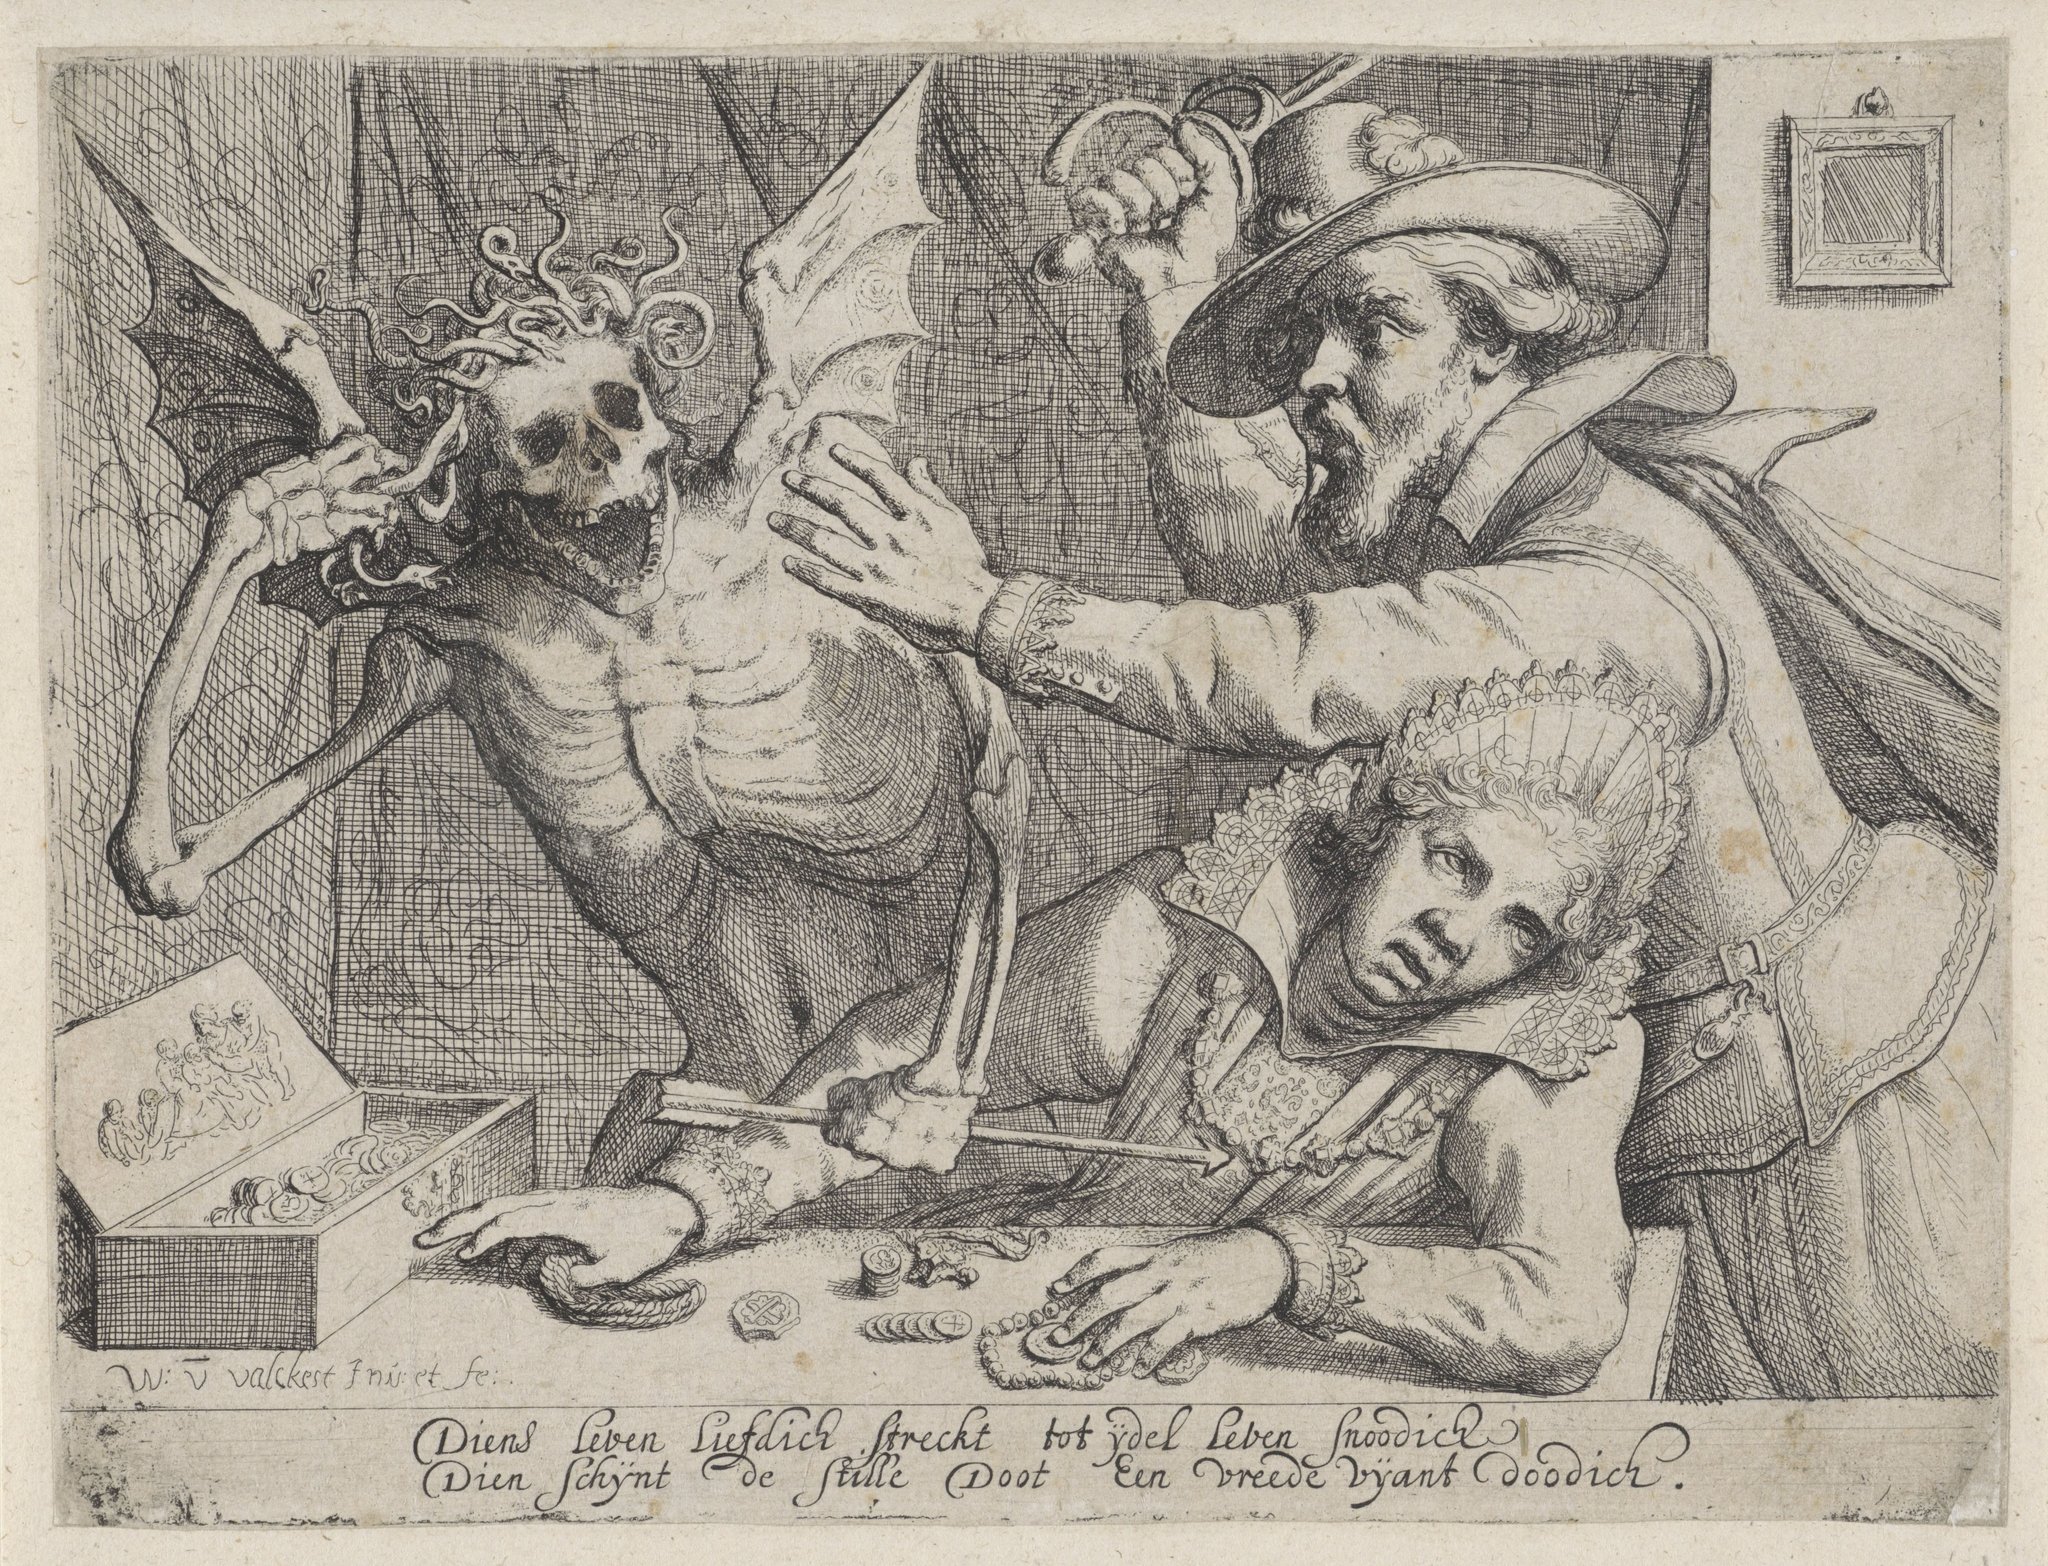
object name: print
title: Jong paar en de Dood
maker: werner van den valckert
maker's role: draughtsman, painter, print maker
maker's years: 1580-1627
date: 1610-1612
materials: paper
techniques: etching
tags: death of a young person, death as skeleton, archer's weapons: arrow, money-chest, treasure-chest, money-box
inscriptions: collector's mark: Lugt 240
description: Een jong paar bij een tafel. Achter de tafel waarop een geopende geldkist, munten en juwelen, wordt de jonge vrouw met een pijl aangevallen door de Dood. De jonge en rijk geklede man valt de Dood aan met zijn zwaard.